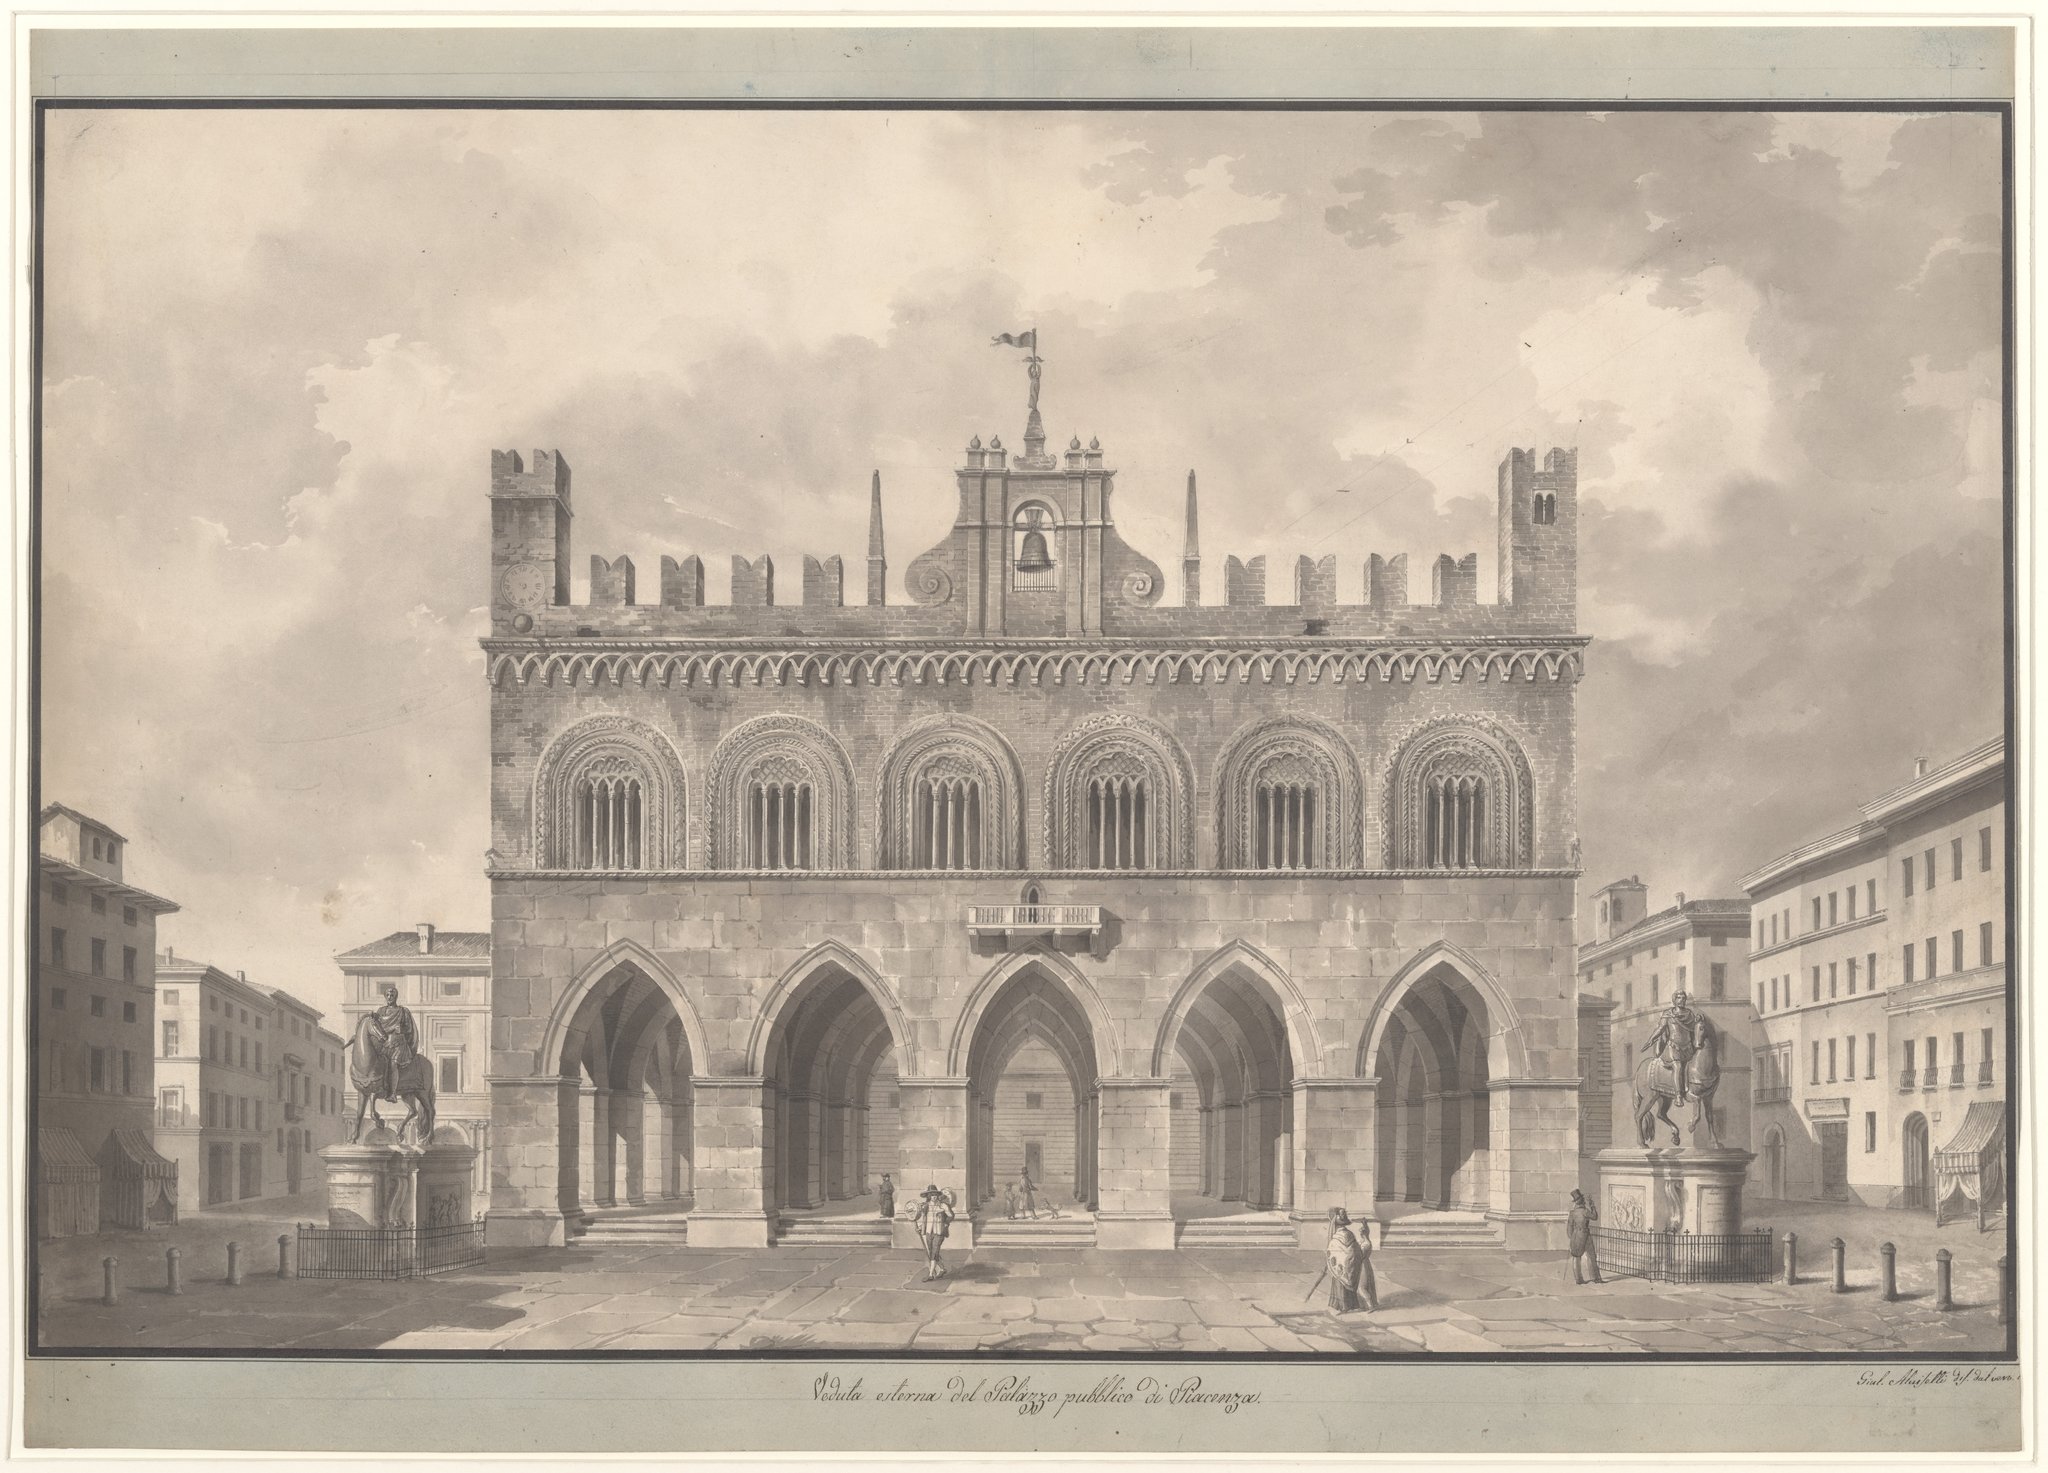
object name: drawing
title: View of the Palazzo Pubblico (Palazzo Comunale), Piacenza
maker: giulio aluisetti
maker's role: artist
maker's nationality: italian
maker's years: 1796-1851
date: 1820-1829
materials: chalk, graphite, ink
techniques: pen, wash